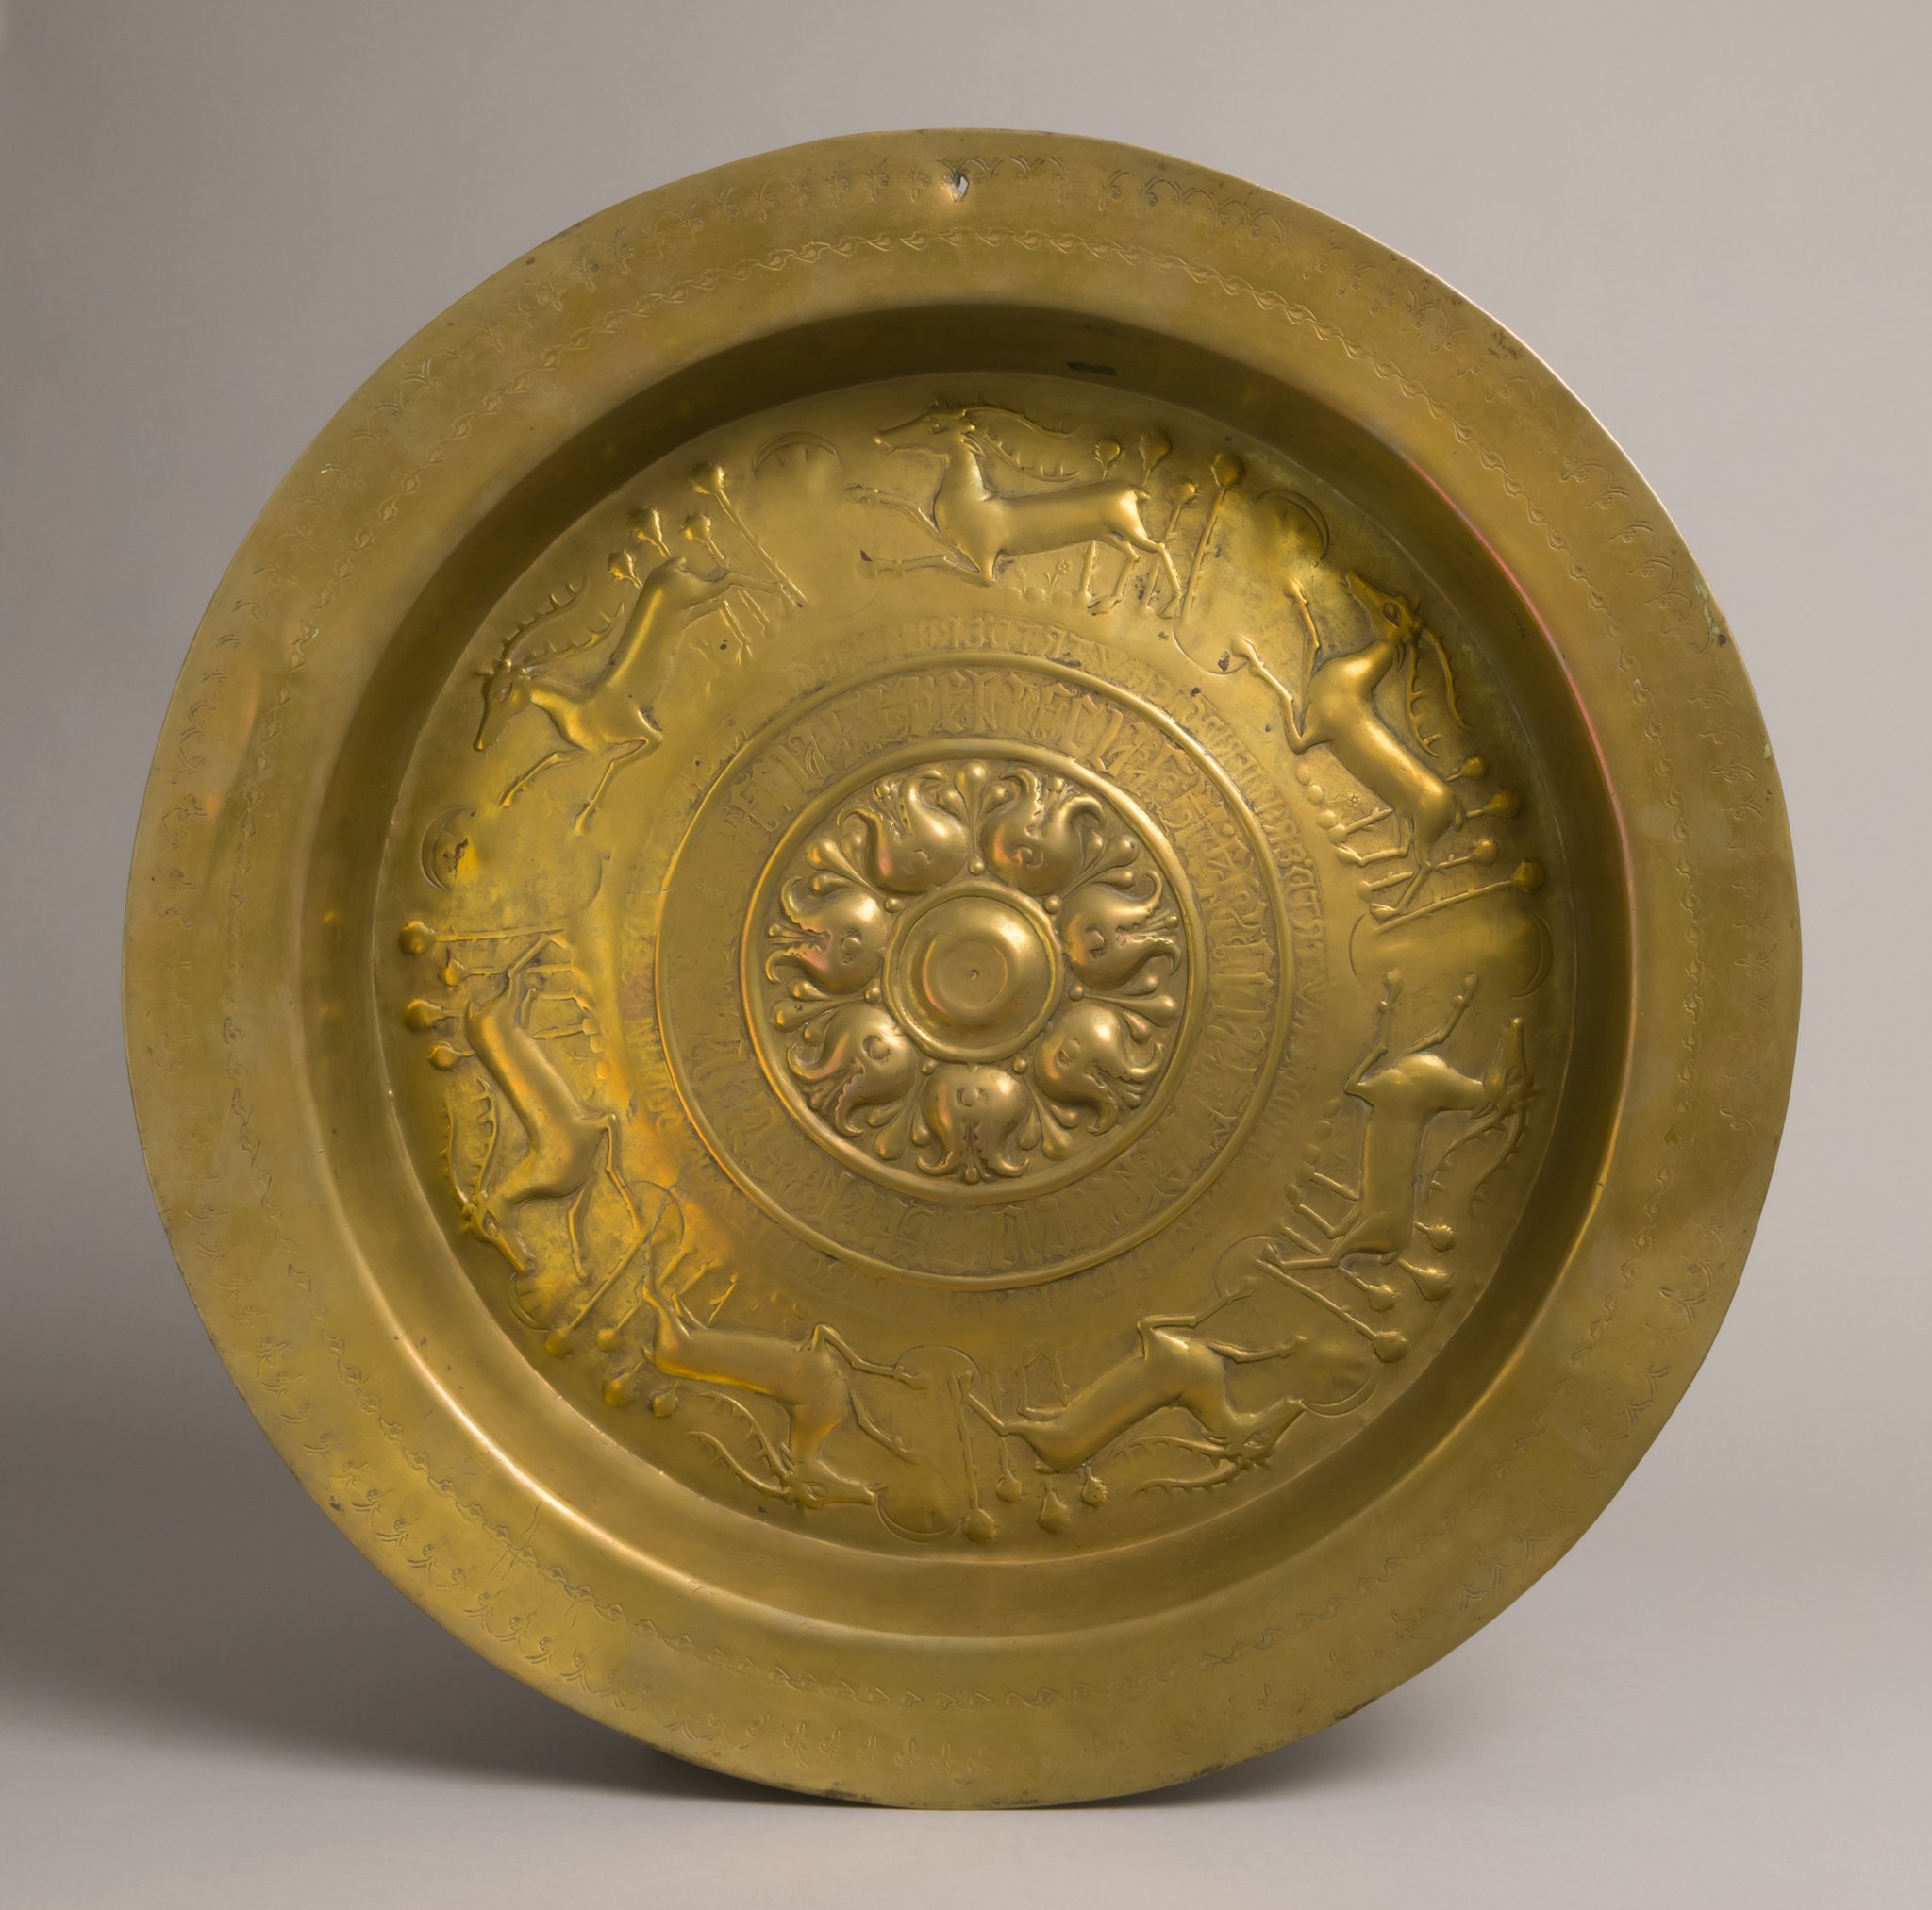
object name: plate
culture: german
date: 1467-1500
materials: brass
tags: deer